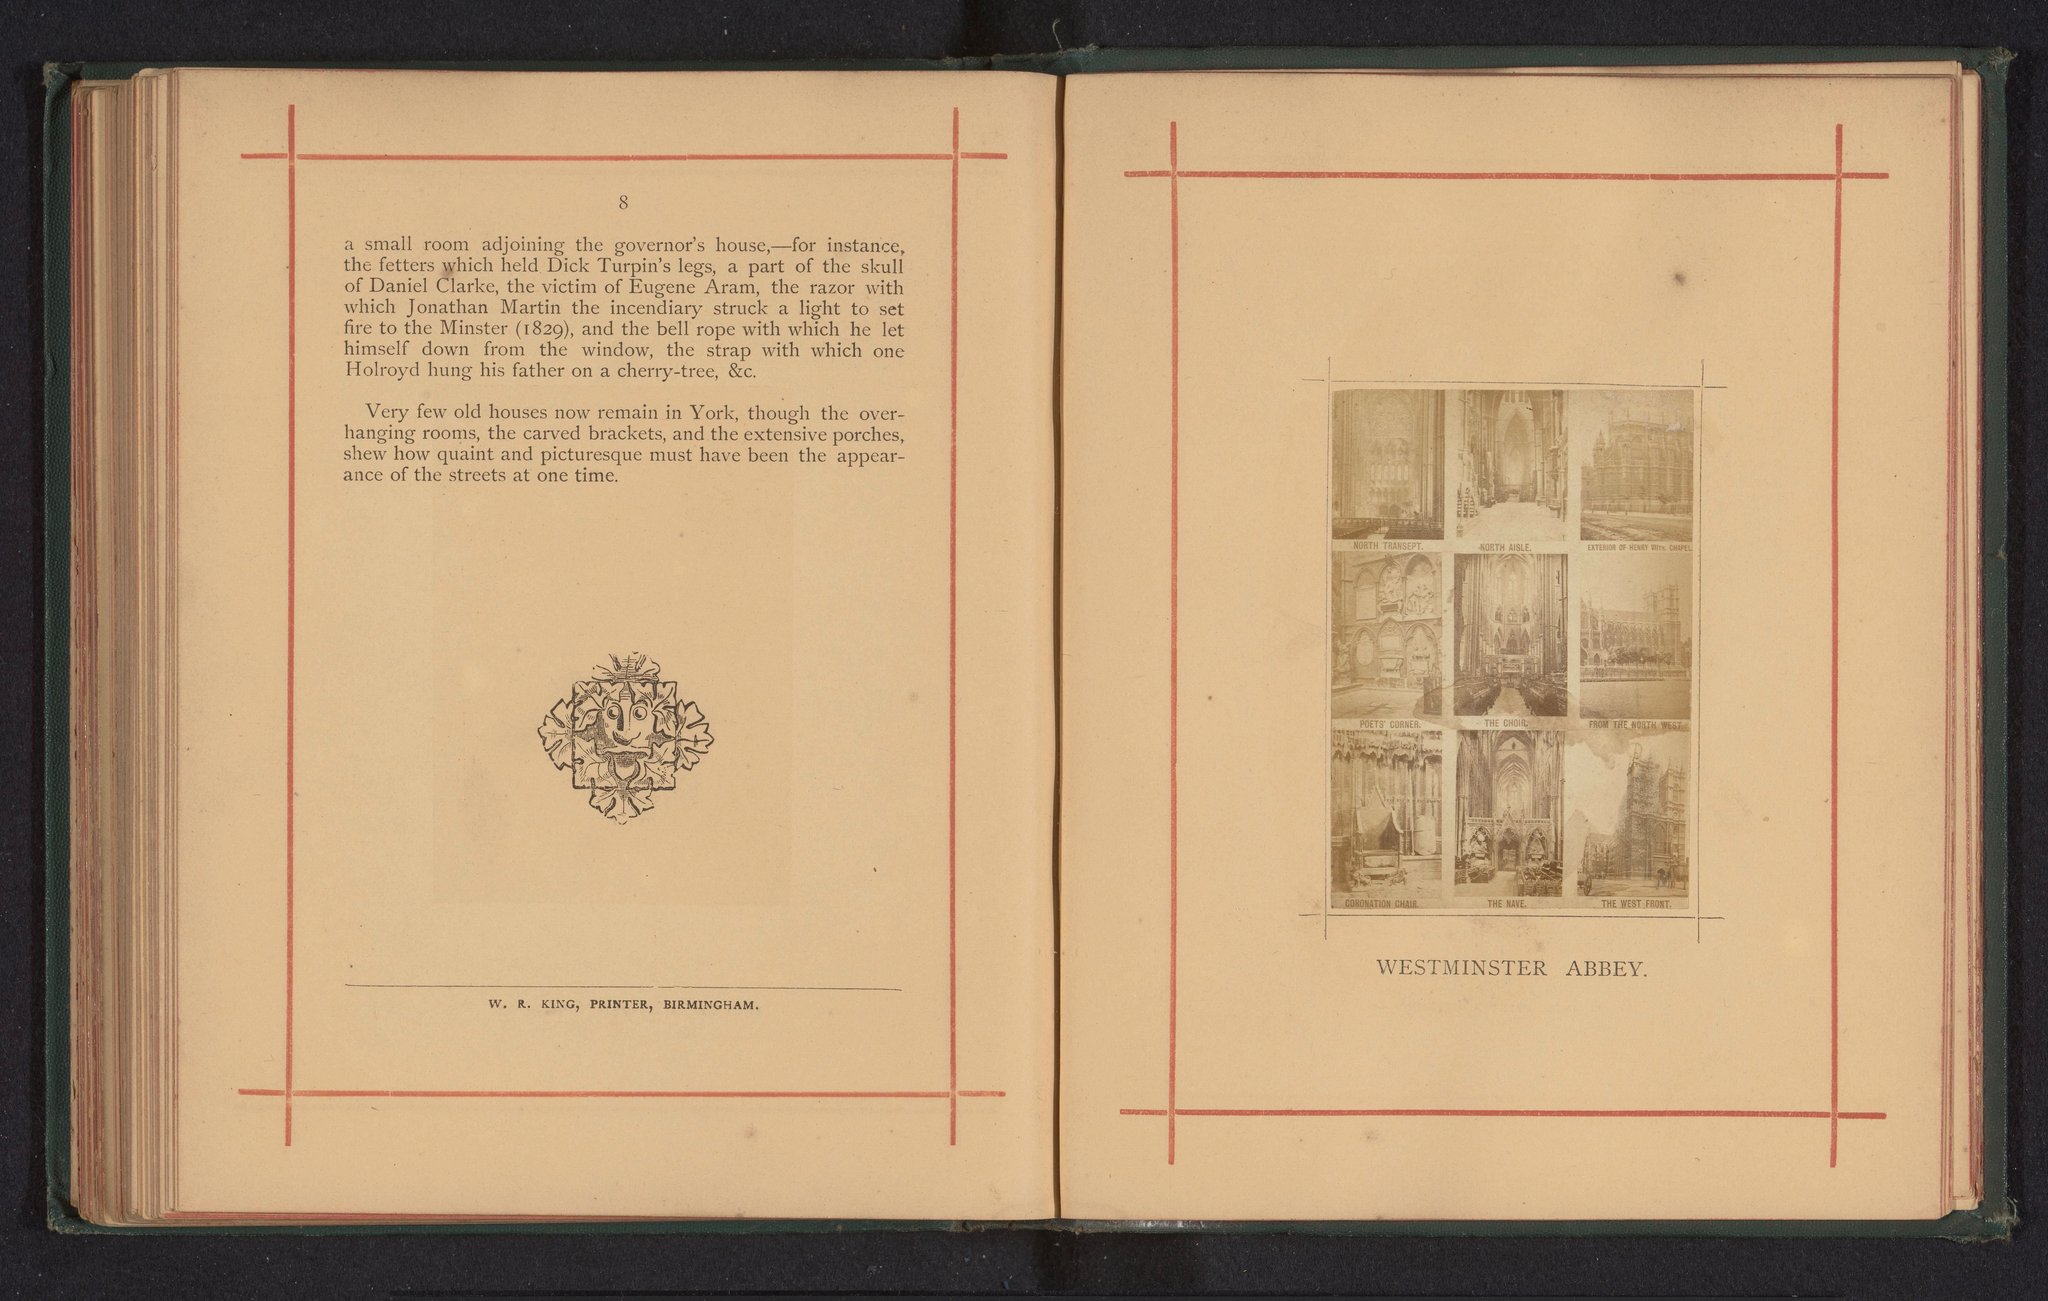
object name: reproduction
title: Westminster Abbey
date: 1870-1880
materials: photographic support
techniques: albumen print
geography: westminster abbey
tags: abbey, monastery, convent ~ roman catholic church, church (exterior), parts of church interior: nave, parts of church interior: choir, westminster abbey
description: Van boven naar beneden en van links naar rechts: het transept, een zijbeuk, exterieur van een kapel, Poet's Corner, het koor, gezicht op de abdij, de kroningsstoel, het schip en een gezicht op de abdij.